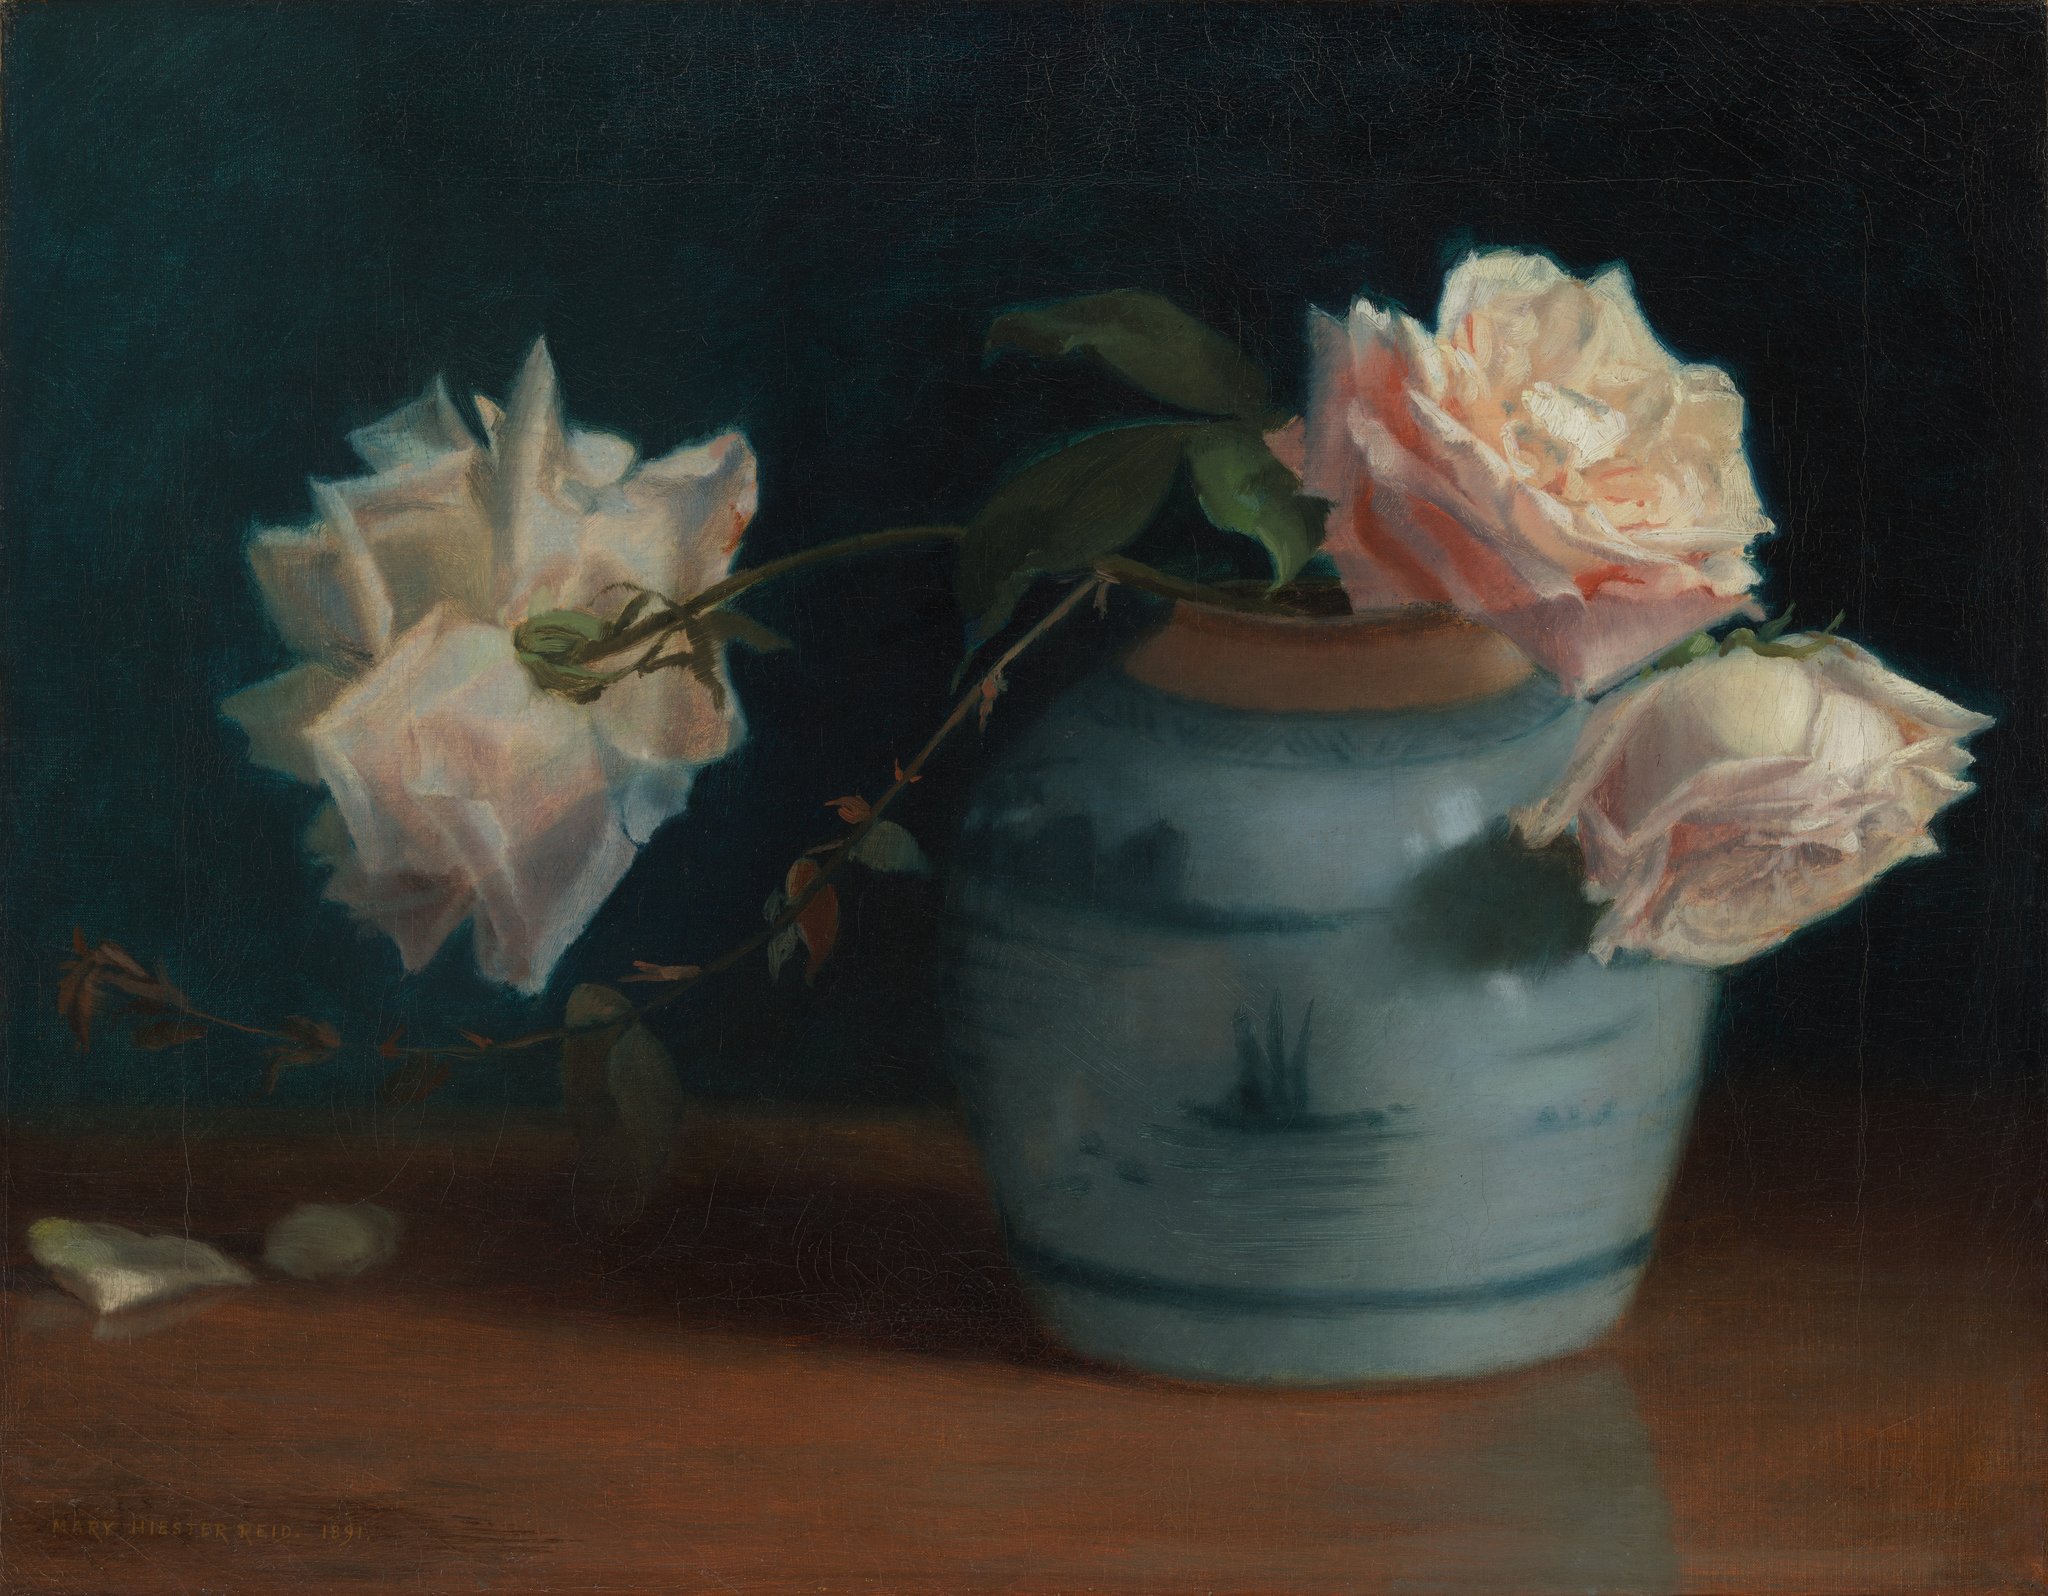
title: Roses in a Vase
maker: mary hiester reid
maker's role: artist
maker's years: 1854-1921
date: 1891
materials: canvas, oil